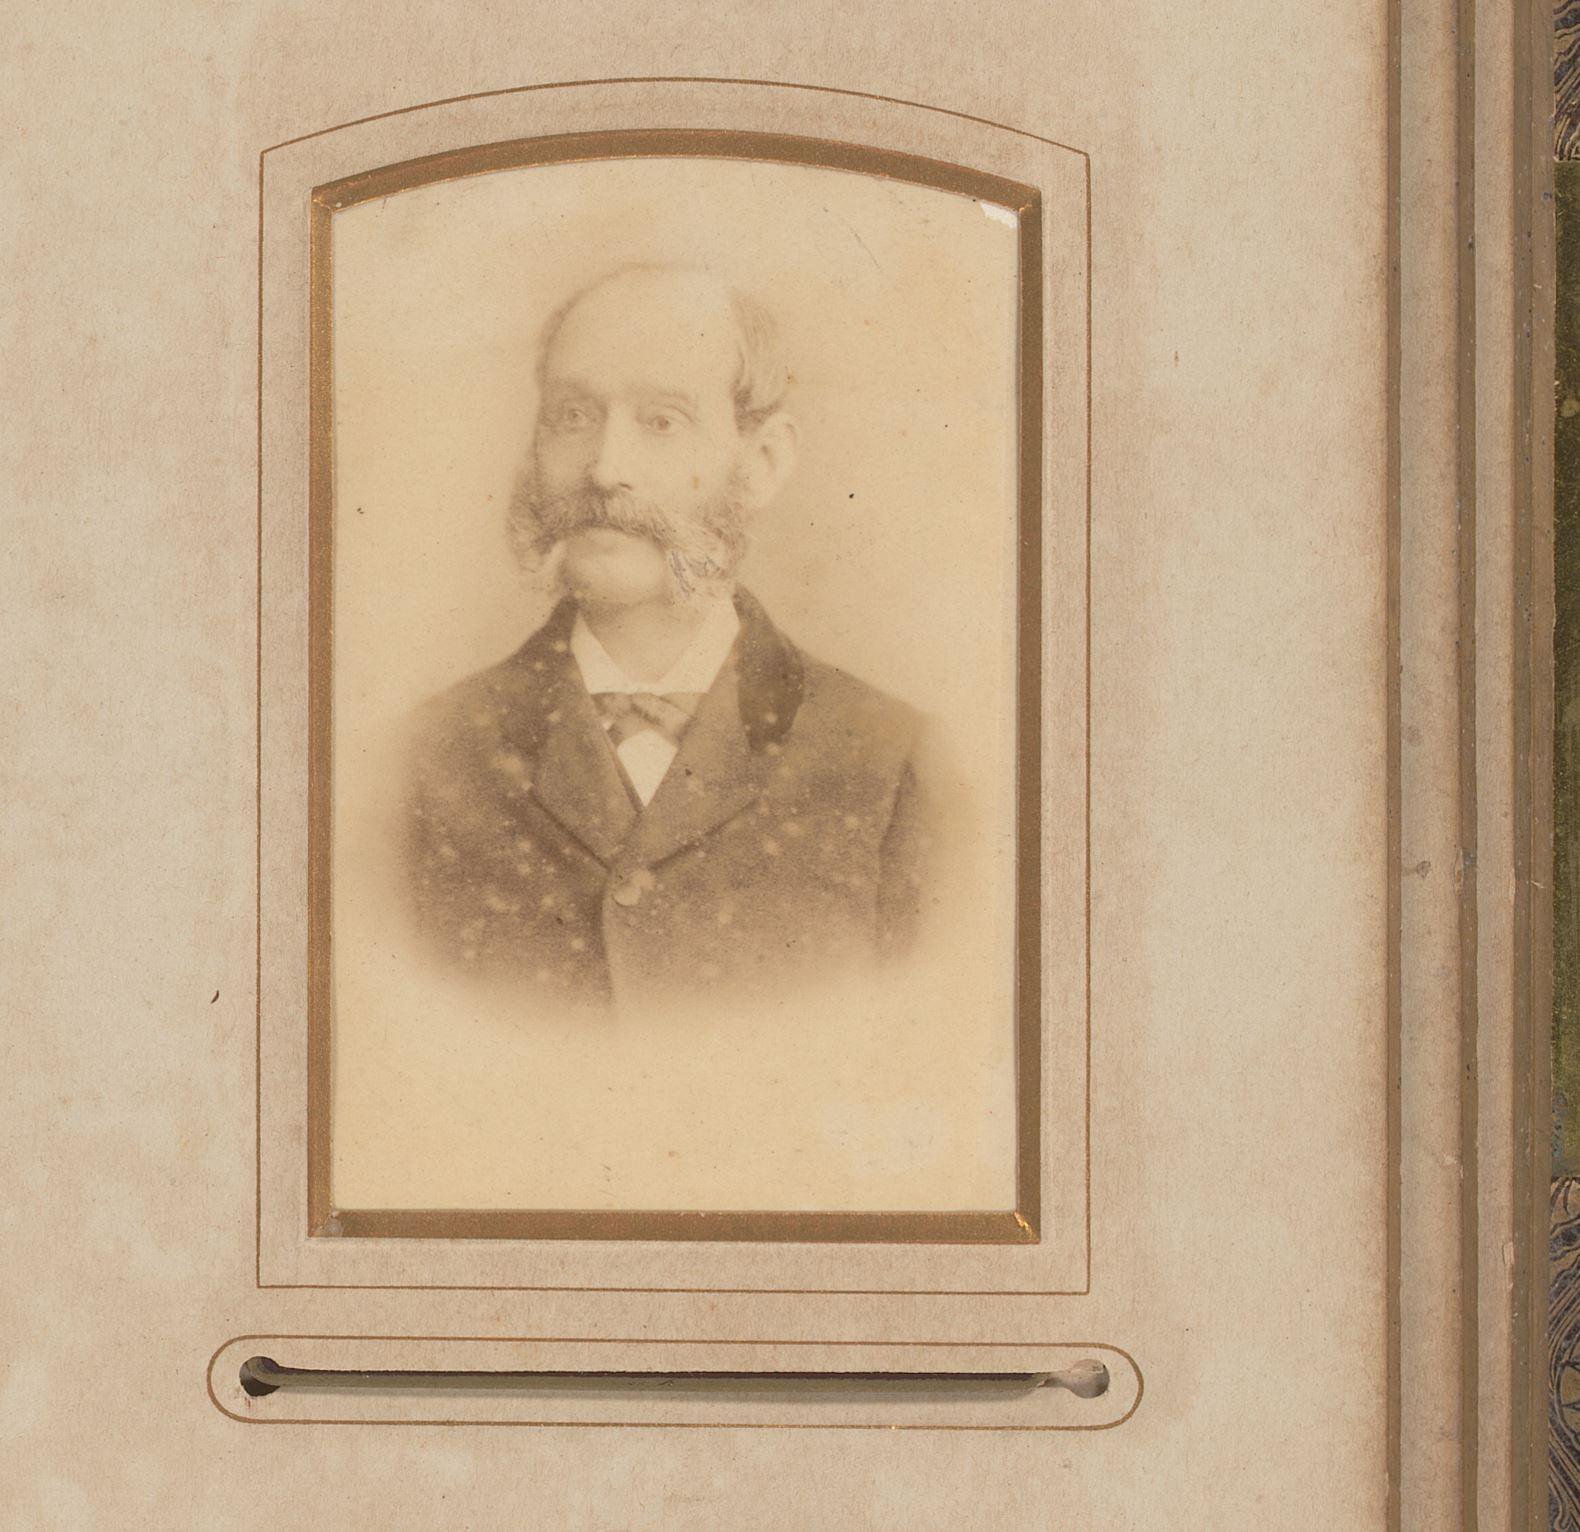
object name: album leaf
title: Portret van een man met snor en bakkebaarden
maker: victor pannelier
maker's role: fotograaf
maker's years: 1840-1914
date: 1880-1900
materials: cardboard, celluloid, photographic support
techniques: albumen print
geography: paris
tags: sideburns, moustache, historical persons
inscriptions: inscription: ‘Photographie/ Artistique de Plaisance/ Victor Pannelier/ 76/ AVENUE DU MAINE/ Paris/ No. Les clichés sont conservés/ Se hable Español’